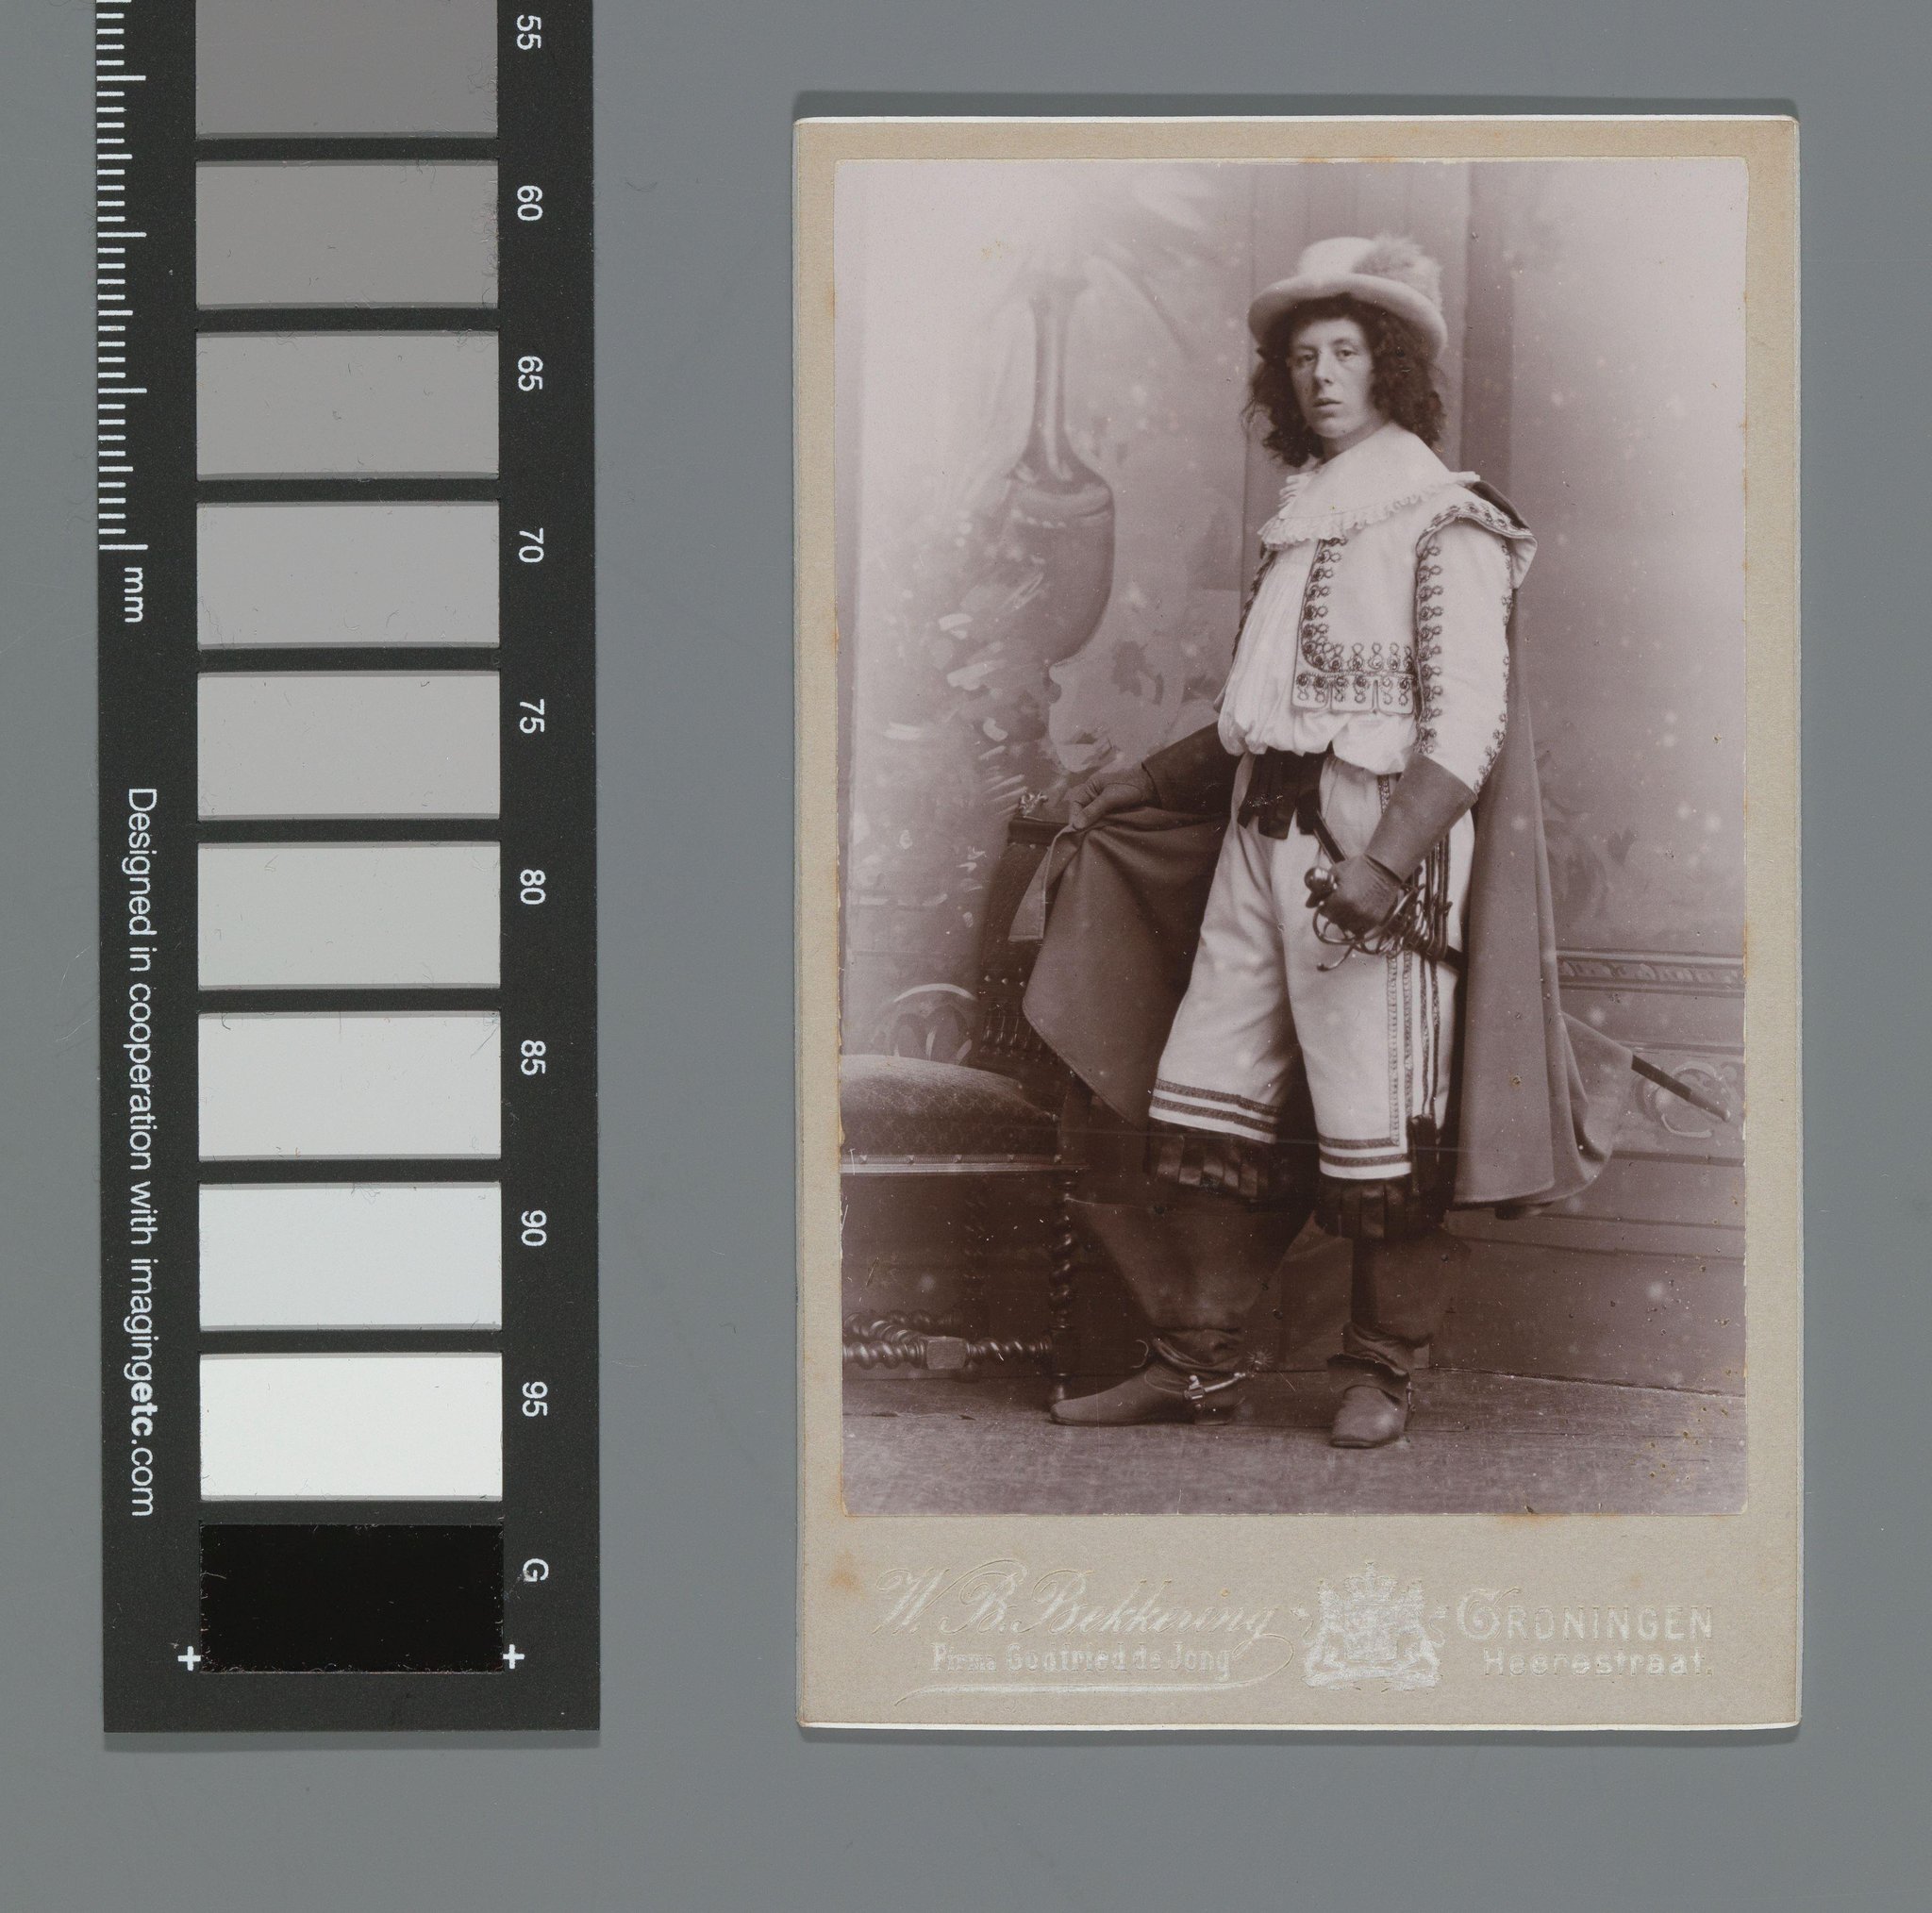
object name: carte de visite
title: Portret van een onbekende Groningse student in maskeradekostuum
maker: willem bernard bekkering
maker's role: painter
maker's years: 1858-1902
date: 1886-1900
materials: paper, cardboard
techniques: collodion silver print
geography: groningen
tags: students' pageant, costumes used in pageants, anonymous historical person portrayed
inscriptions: inscription: ‘W.B. Bekkering/ Firma Godfried de Jong/ Groningen/ Heerestraat’